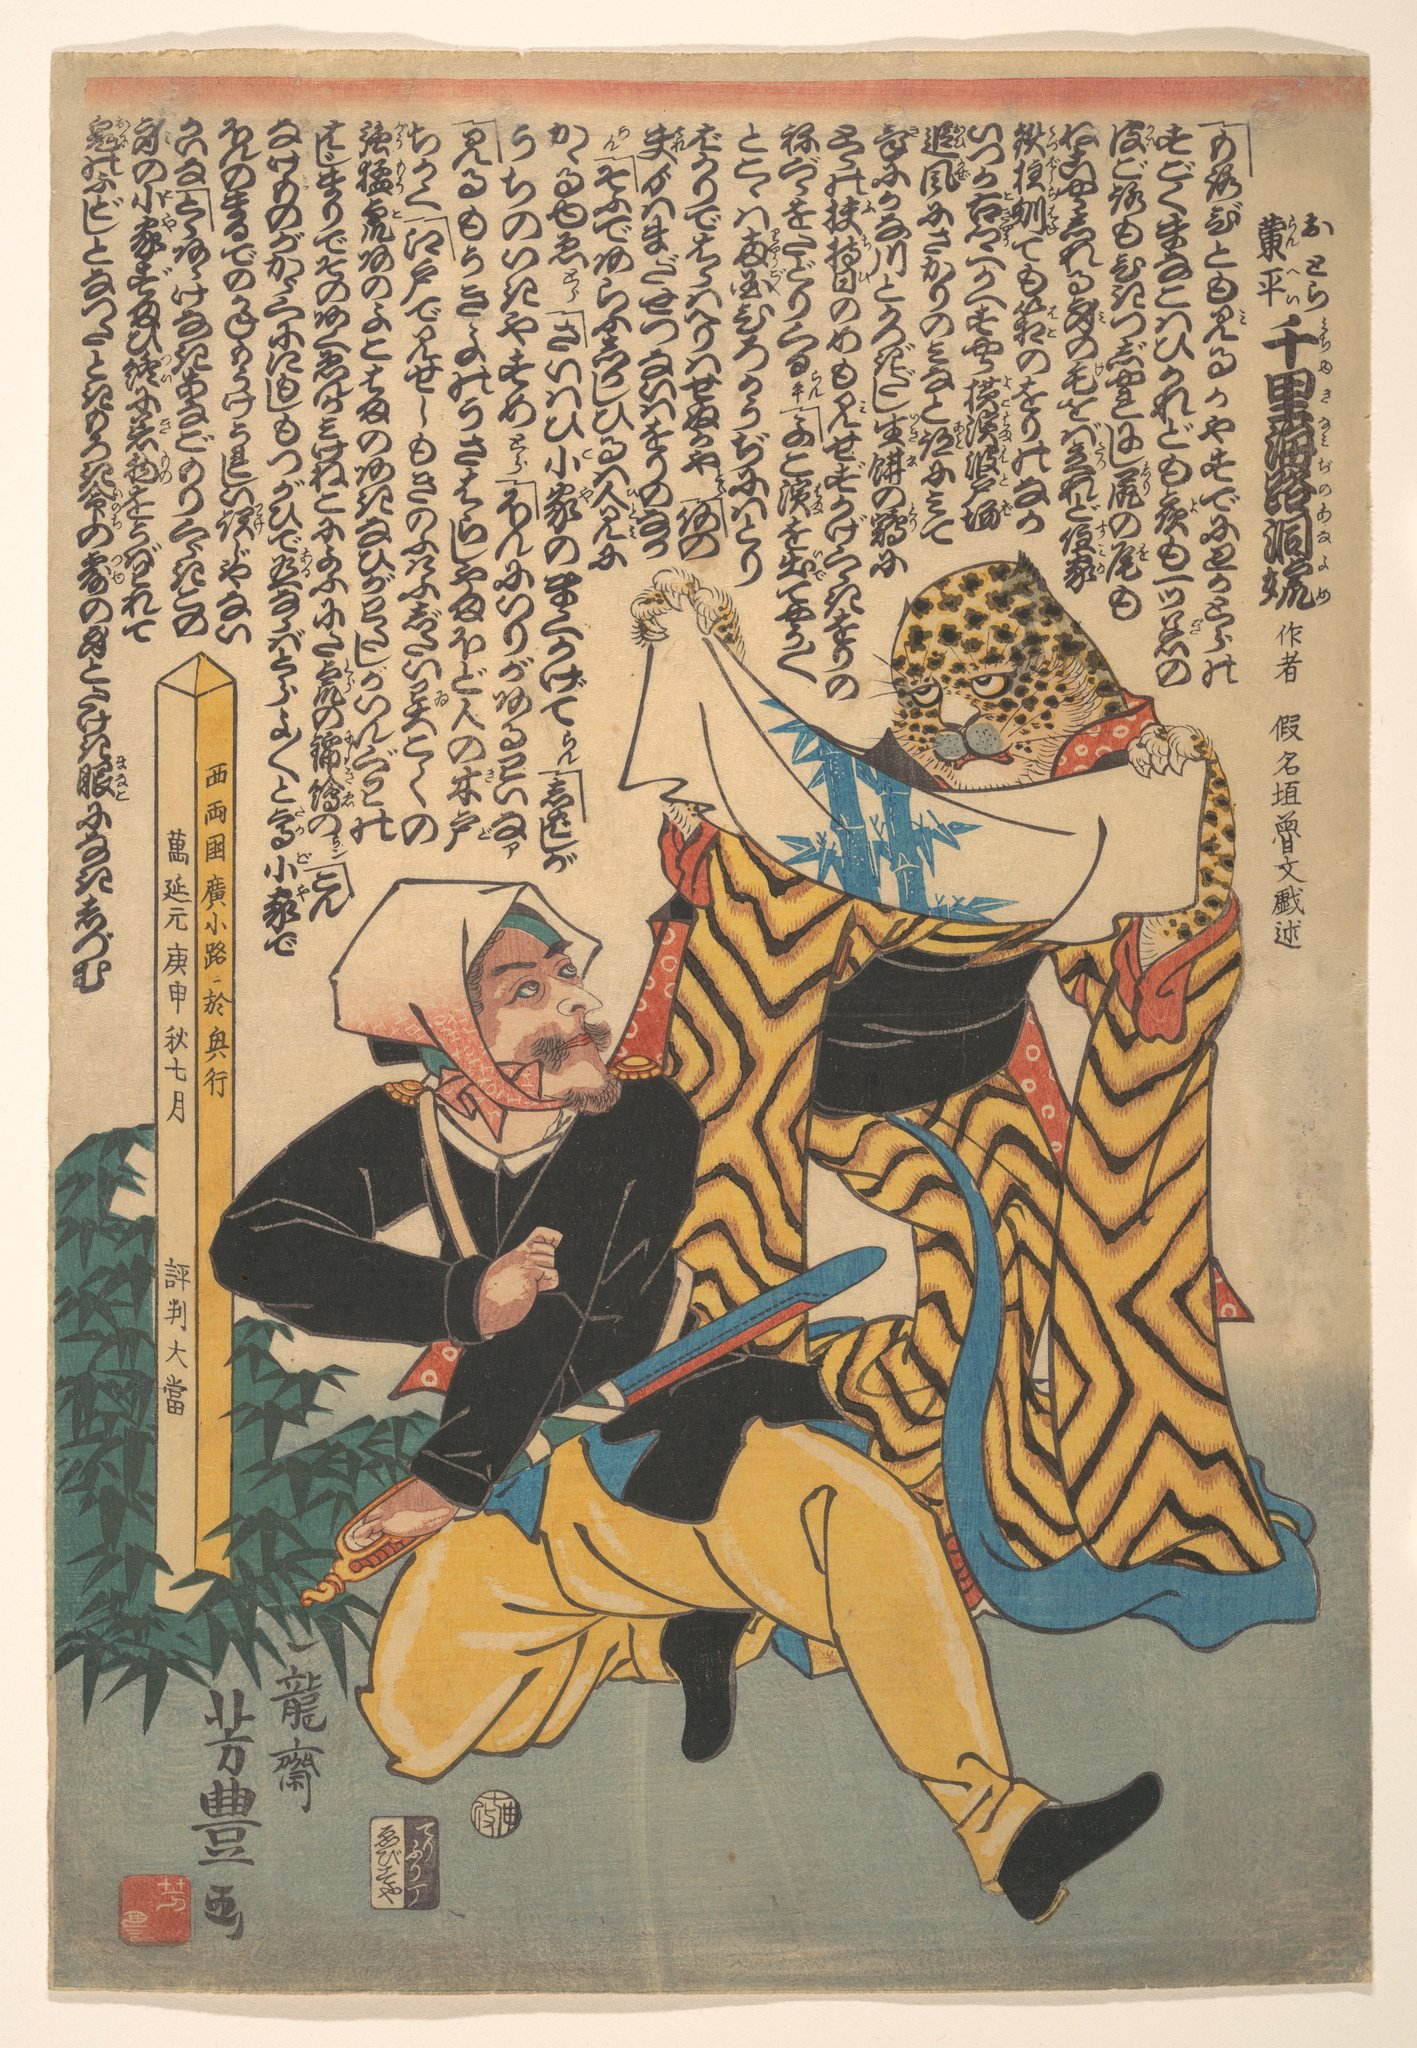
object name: print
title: A Foreigner and a Leopard Disguised as a Woman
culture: japanese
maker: ichiryūsai yoshitoyo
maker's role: artist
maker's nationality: japanese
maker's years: 1830-1866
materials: ink, paper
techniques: woodblock print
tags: swords,men,leopards